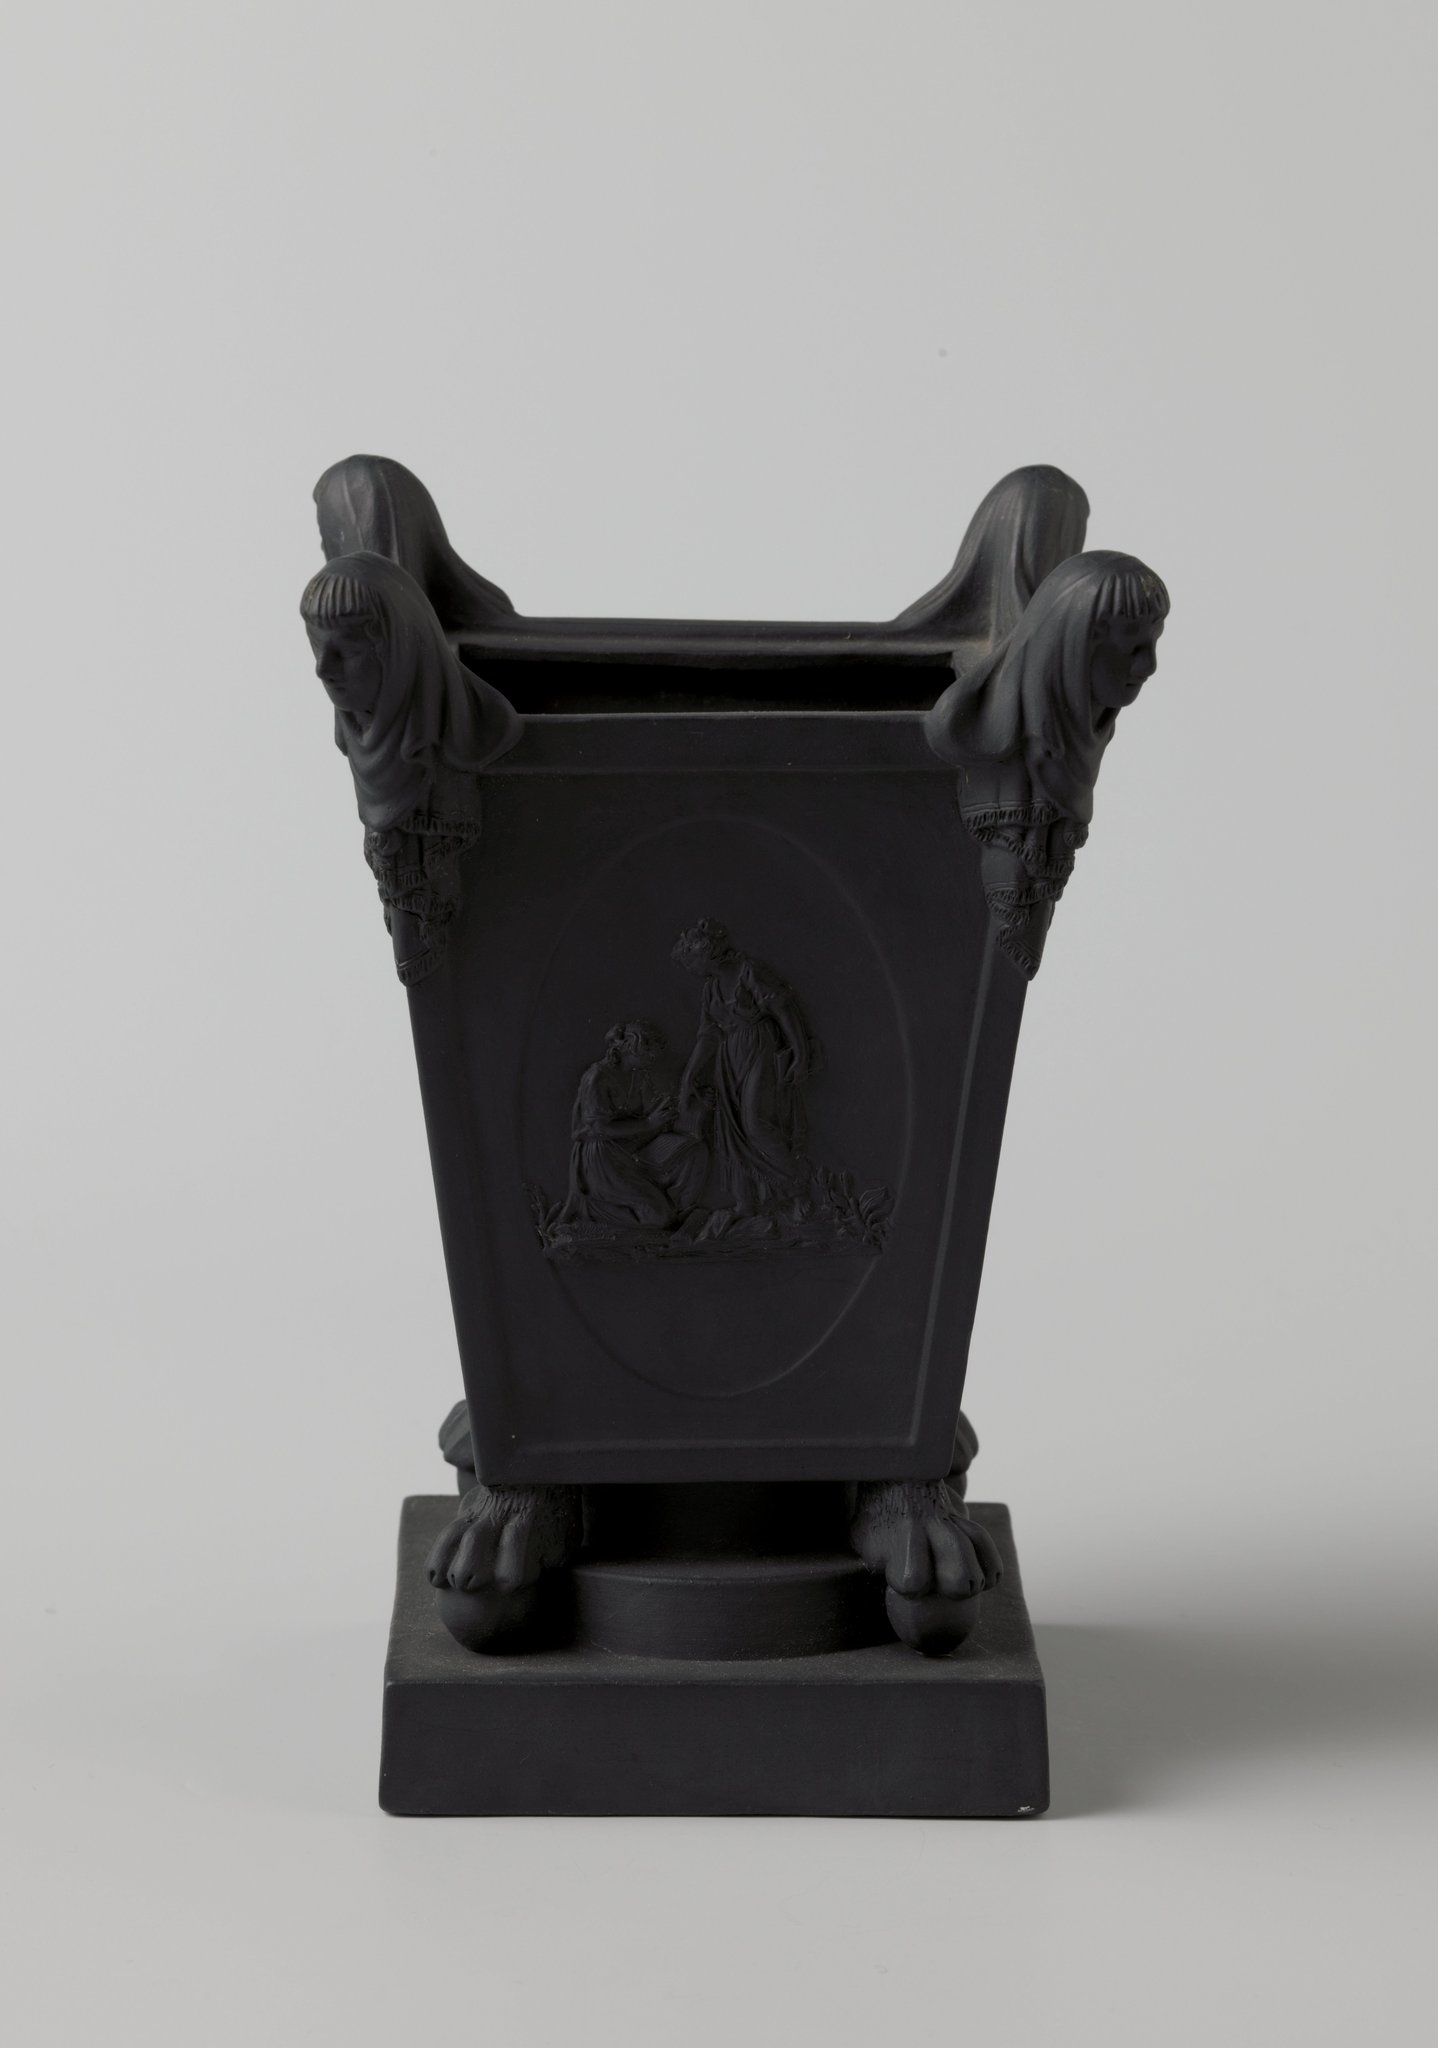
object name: decoratief object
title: Vaas van aardewerk, Turner type Black Basalt.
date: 1775-1790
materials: earthenware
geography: england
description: Omgekeerd piramidale vaas van aardewerk, Turner Black Basalt. De vaas staat op een vierkant basement. De vaas heeft op de vier bovenhoeken vrouwenkoppen en onder de vier benedenhoeken een klauw op een bol. De wanden hebben decoraties in reliëf van een dansende figuur, een vrouw die een krans plaatst op een portretbuste, een vrouw zittend op een rots met de hoorn des overvloeds en een knielende en een staande vrouw met een boek. De vaas is gemerkt.